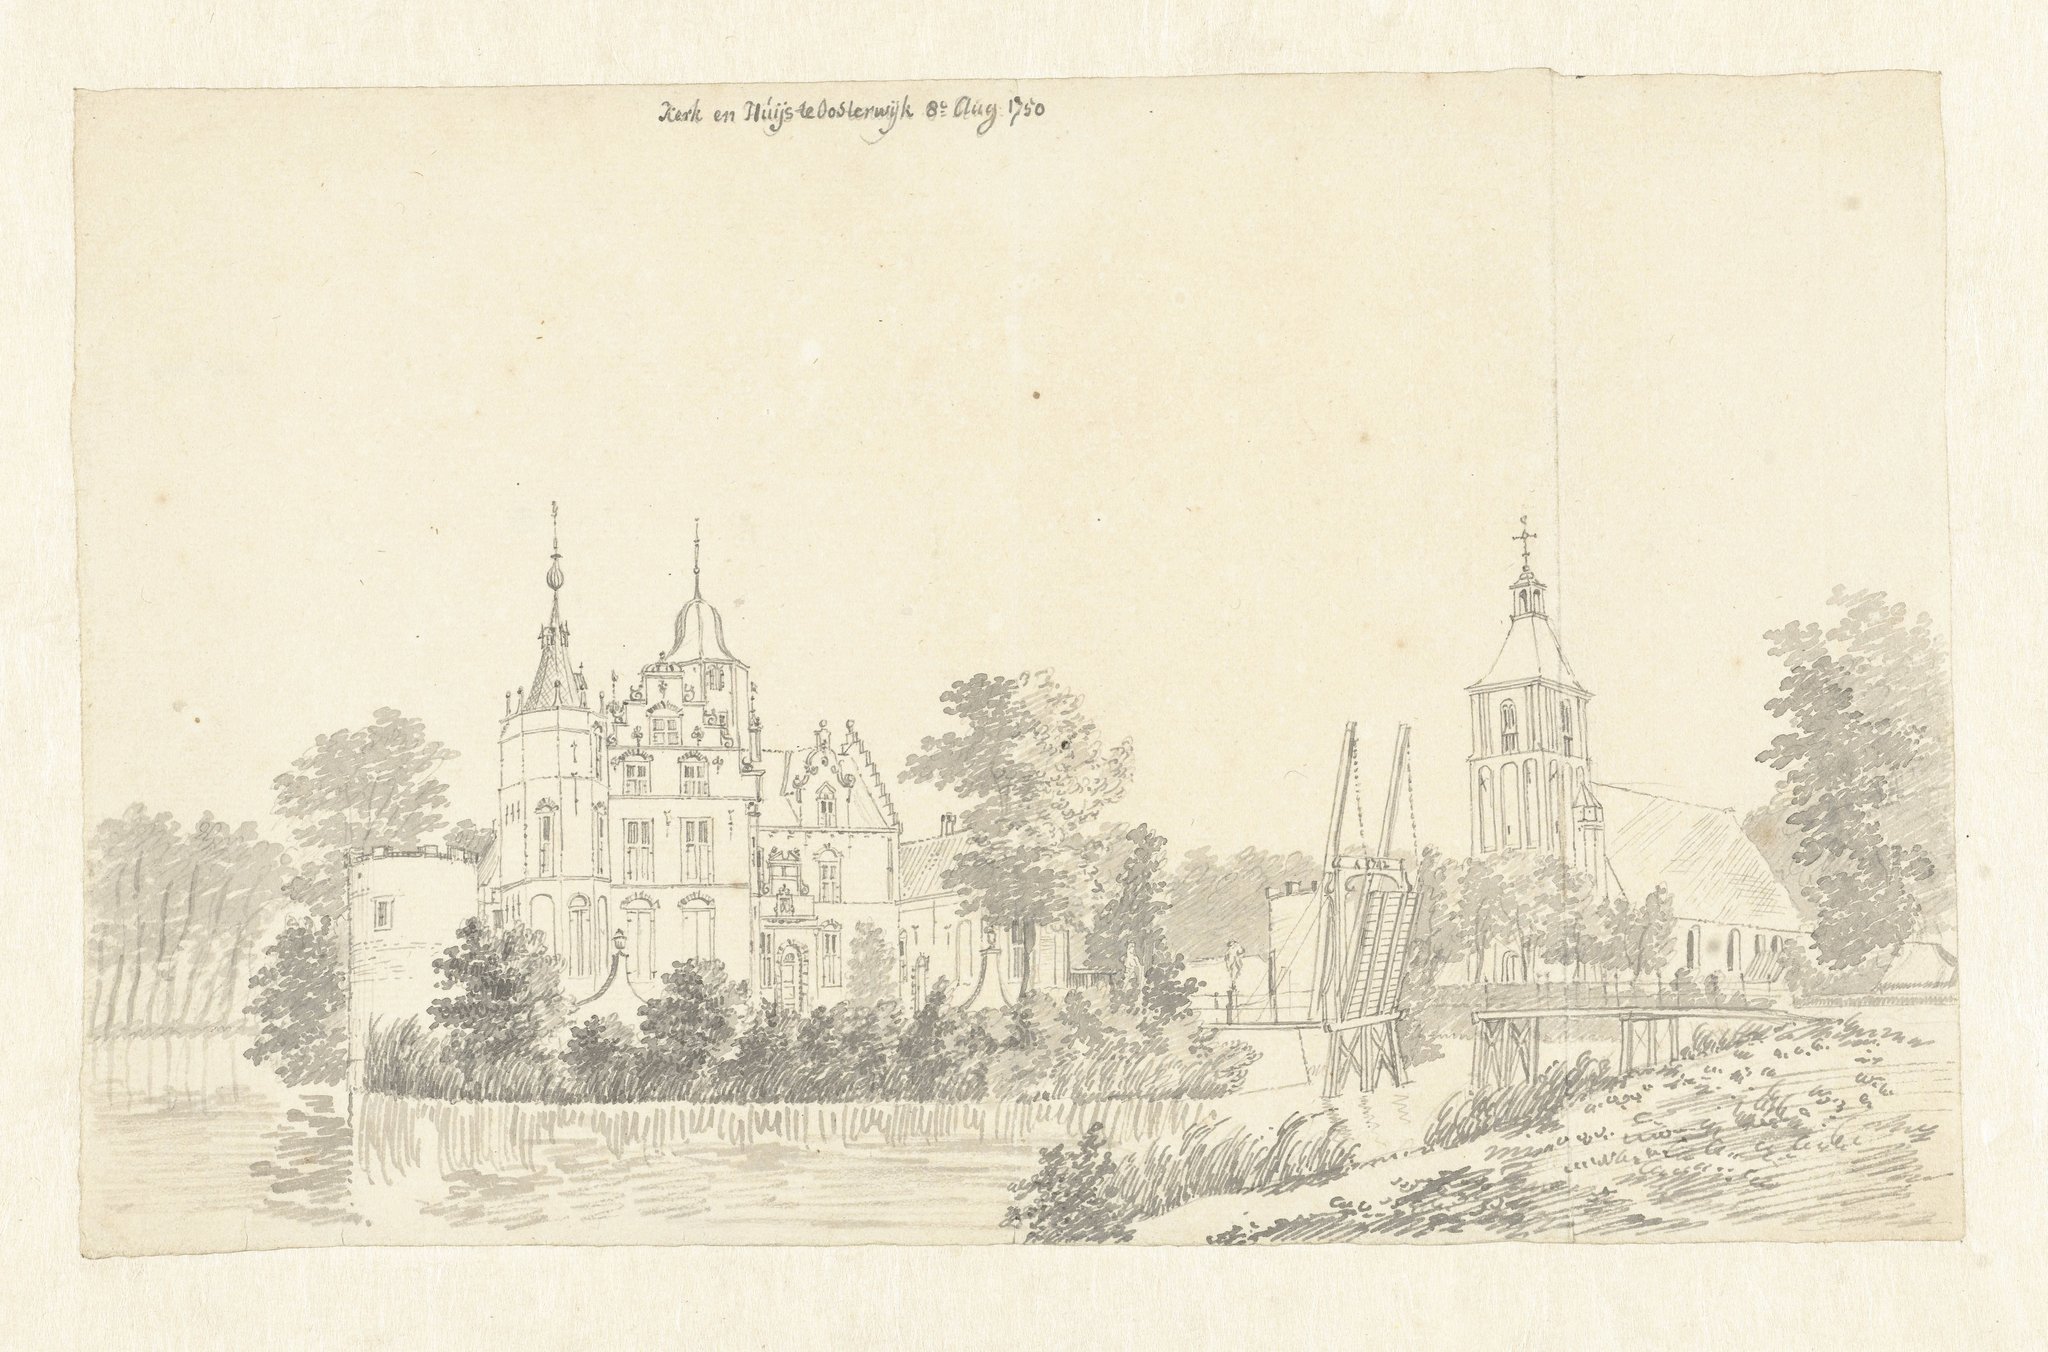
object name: drawing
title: Kerk en Huis te Oosterwijk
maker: jan de beijer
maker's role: draughtsman, print maker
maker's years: 1703-1780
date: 1750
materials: ink, paper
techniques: brush, pen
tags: castle, church (exterior), prospect of city, town panorama, silhouette of city, oosterwijk